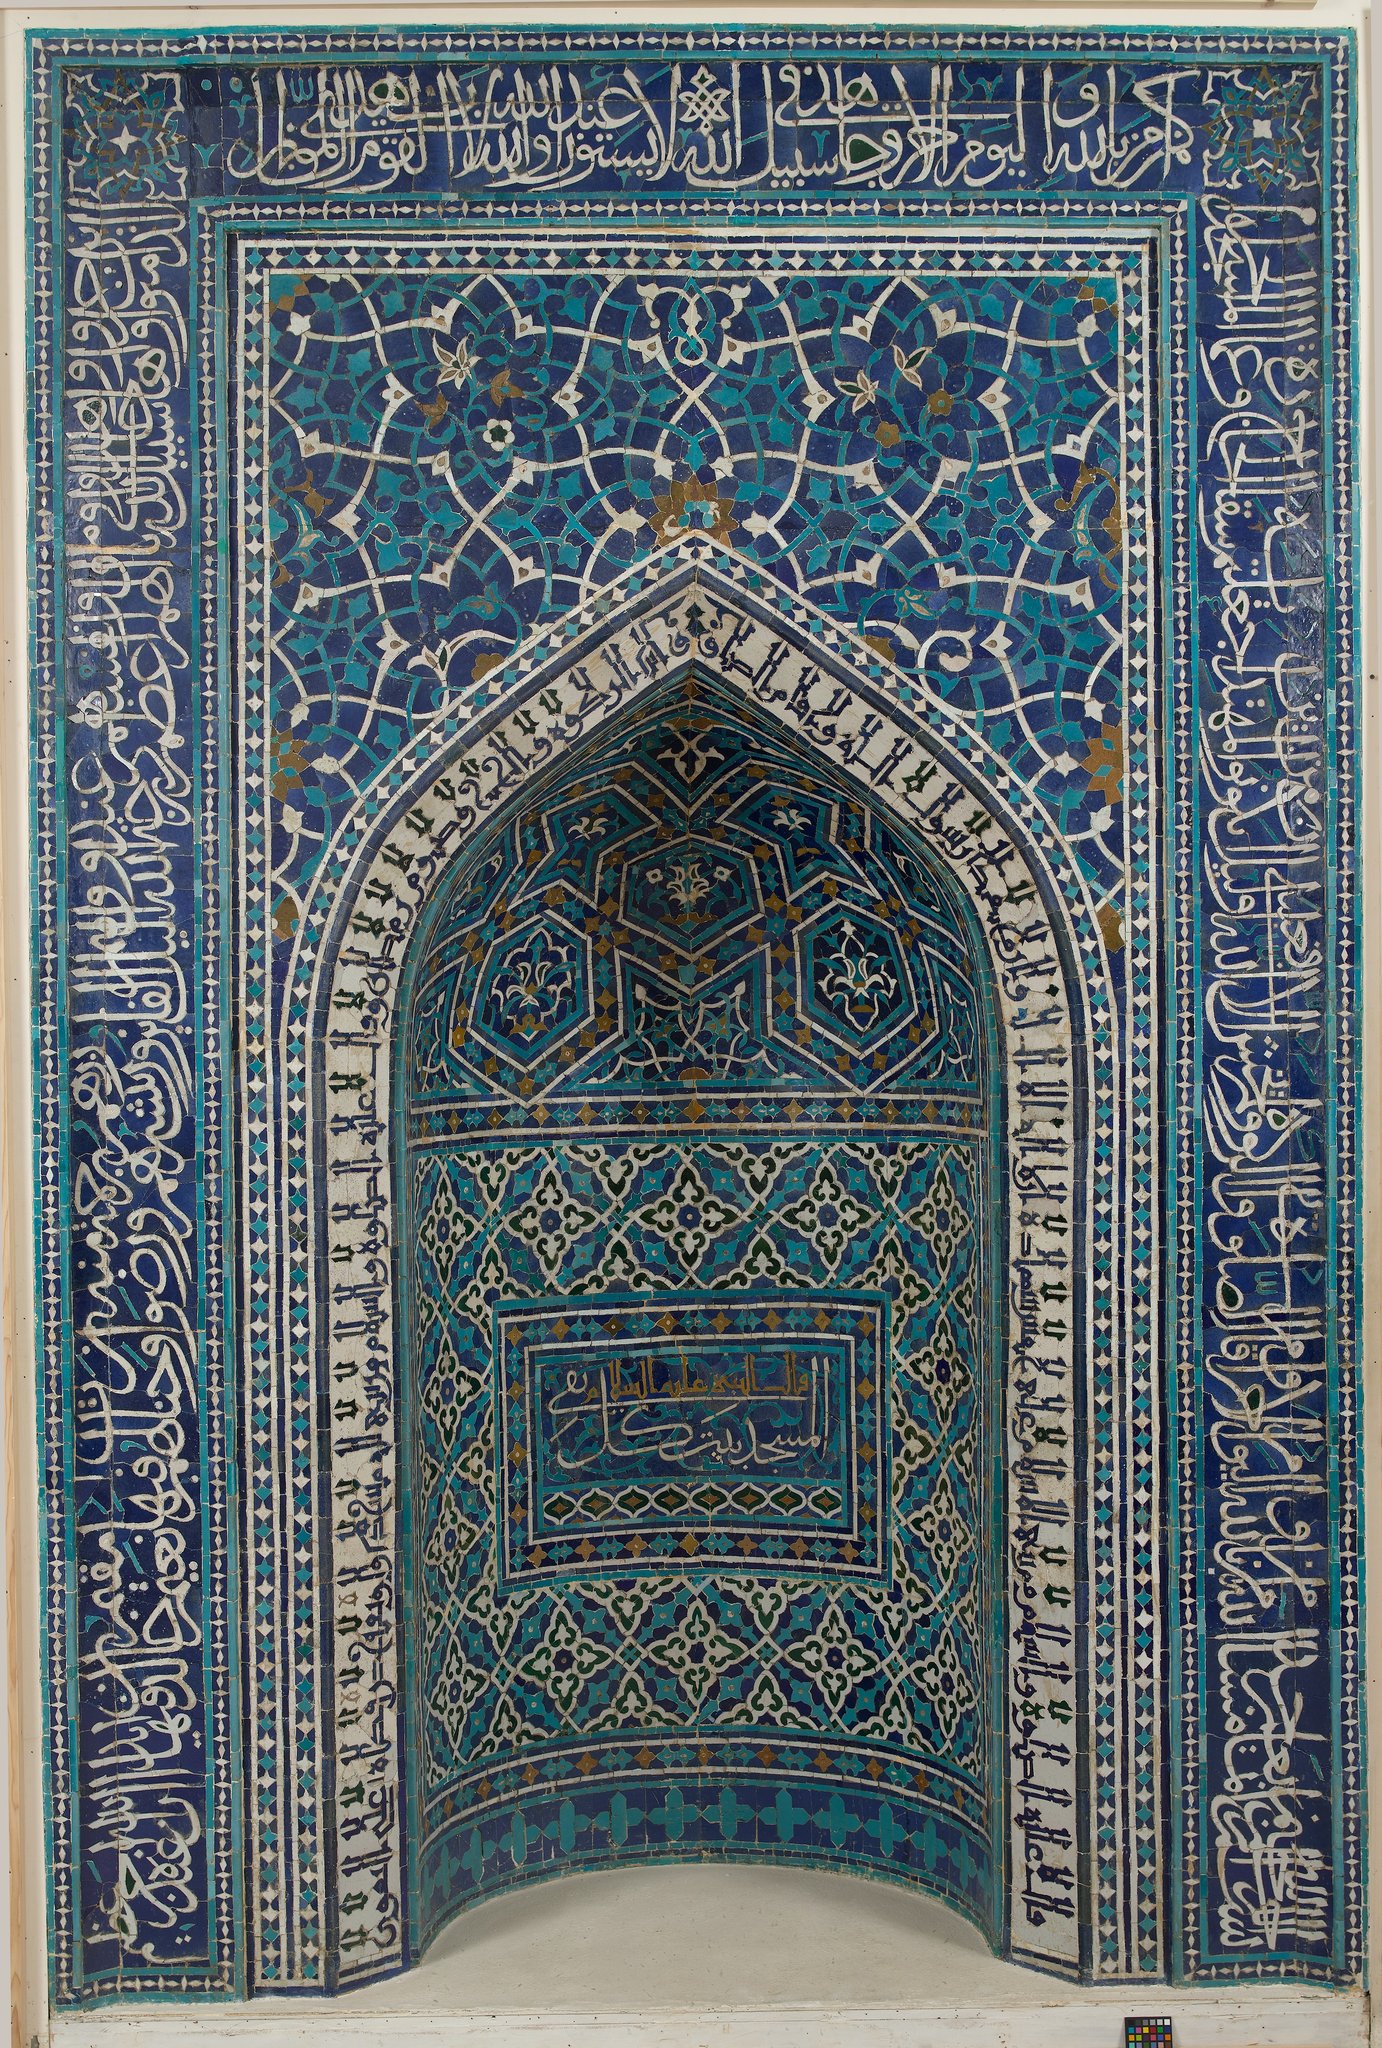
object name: mihrab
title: Mihrab (Prayer Niche)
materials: mortar, stonepaste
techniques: cutting, glazing, polychrome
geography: iran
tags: arabic